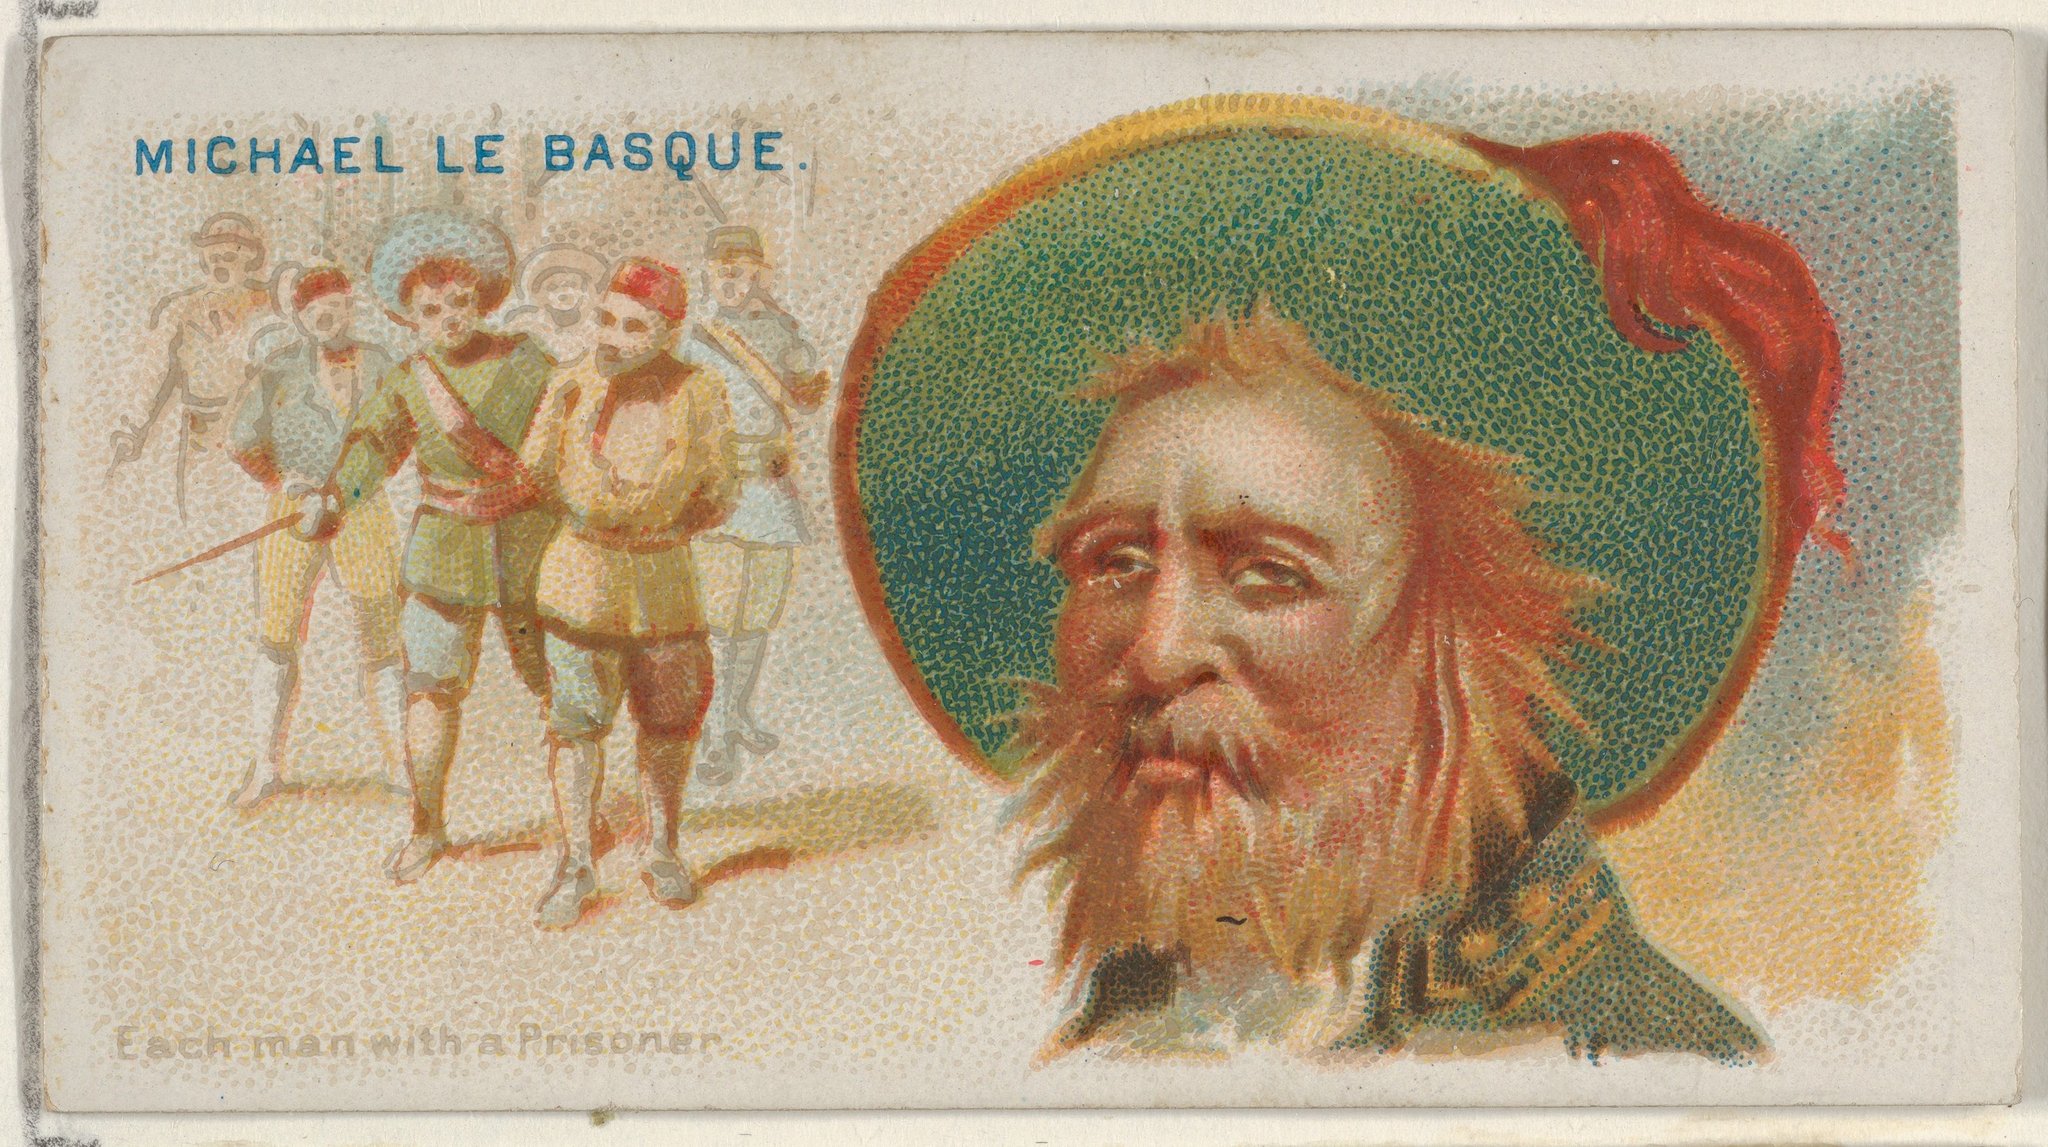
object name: print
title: Michael Le Basque, Each Man with a Prisoner, from the Pirates of the Spanish Main series (N19) for Allen & Ginter Cigarettes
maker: allen & ginter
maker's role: publisher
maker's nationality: american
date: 1888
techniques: color lithograph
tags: prisoners,men